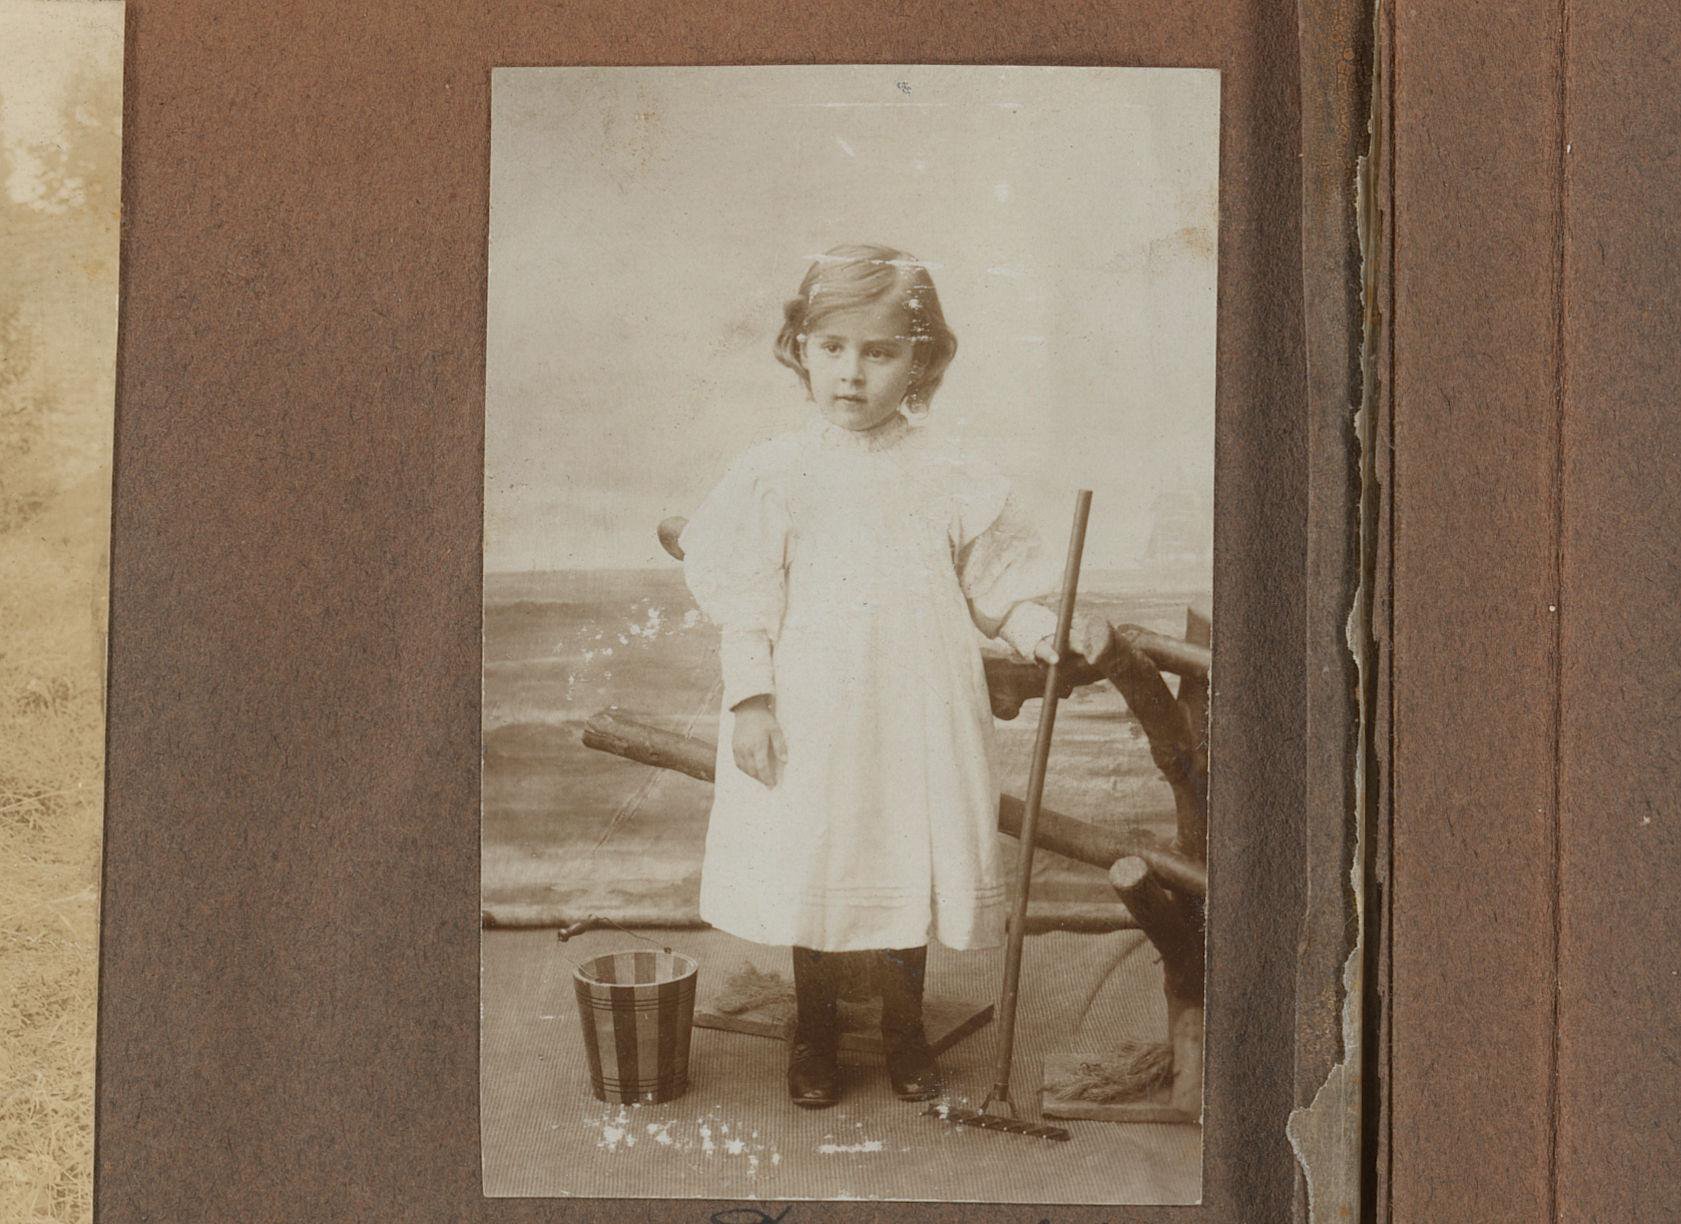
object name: photograph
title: Studioportret Daisy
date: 1896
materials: photographic support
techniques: photography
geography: amsterdam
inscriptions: inscription: ‘Daisy 1896.’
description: Foto op bruin albumblad 24 van familiealbum van Alphons Diepenbrock.